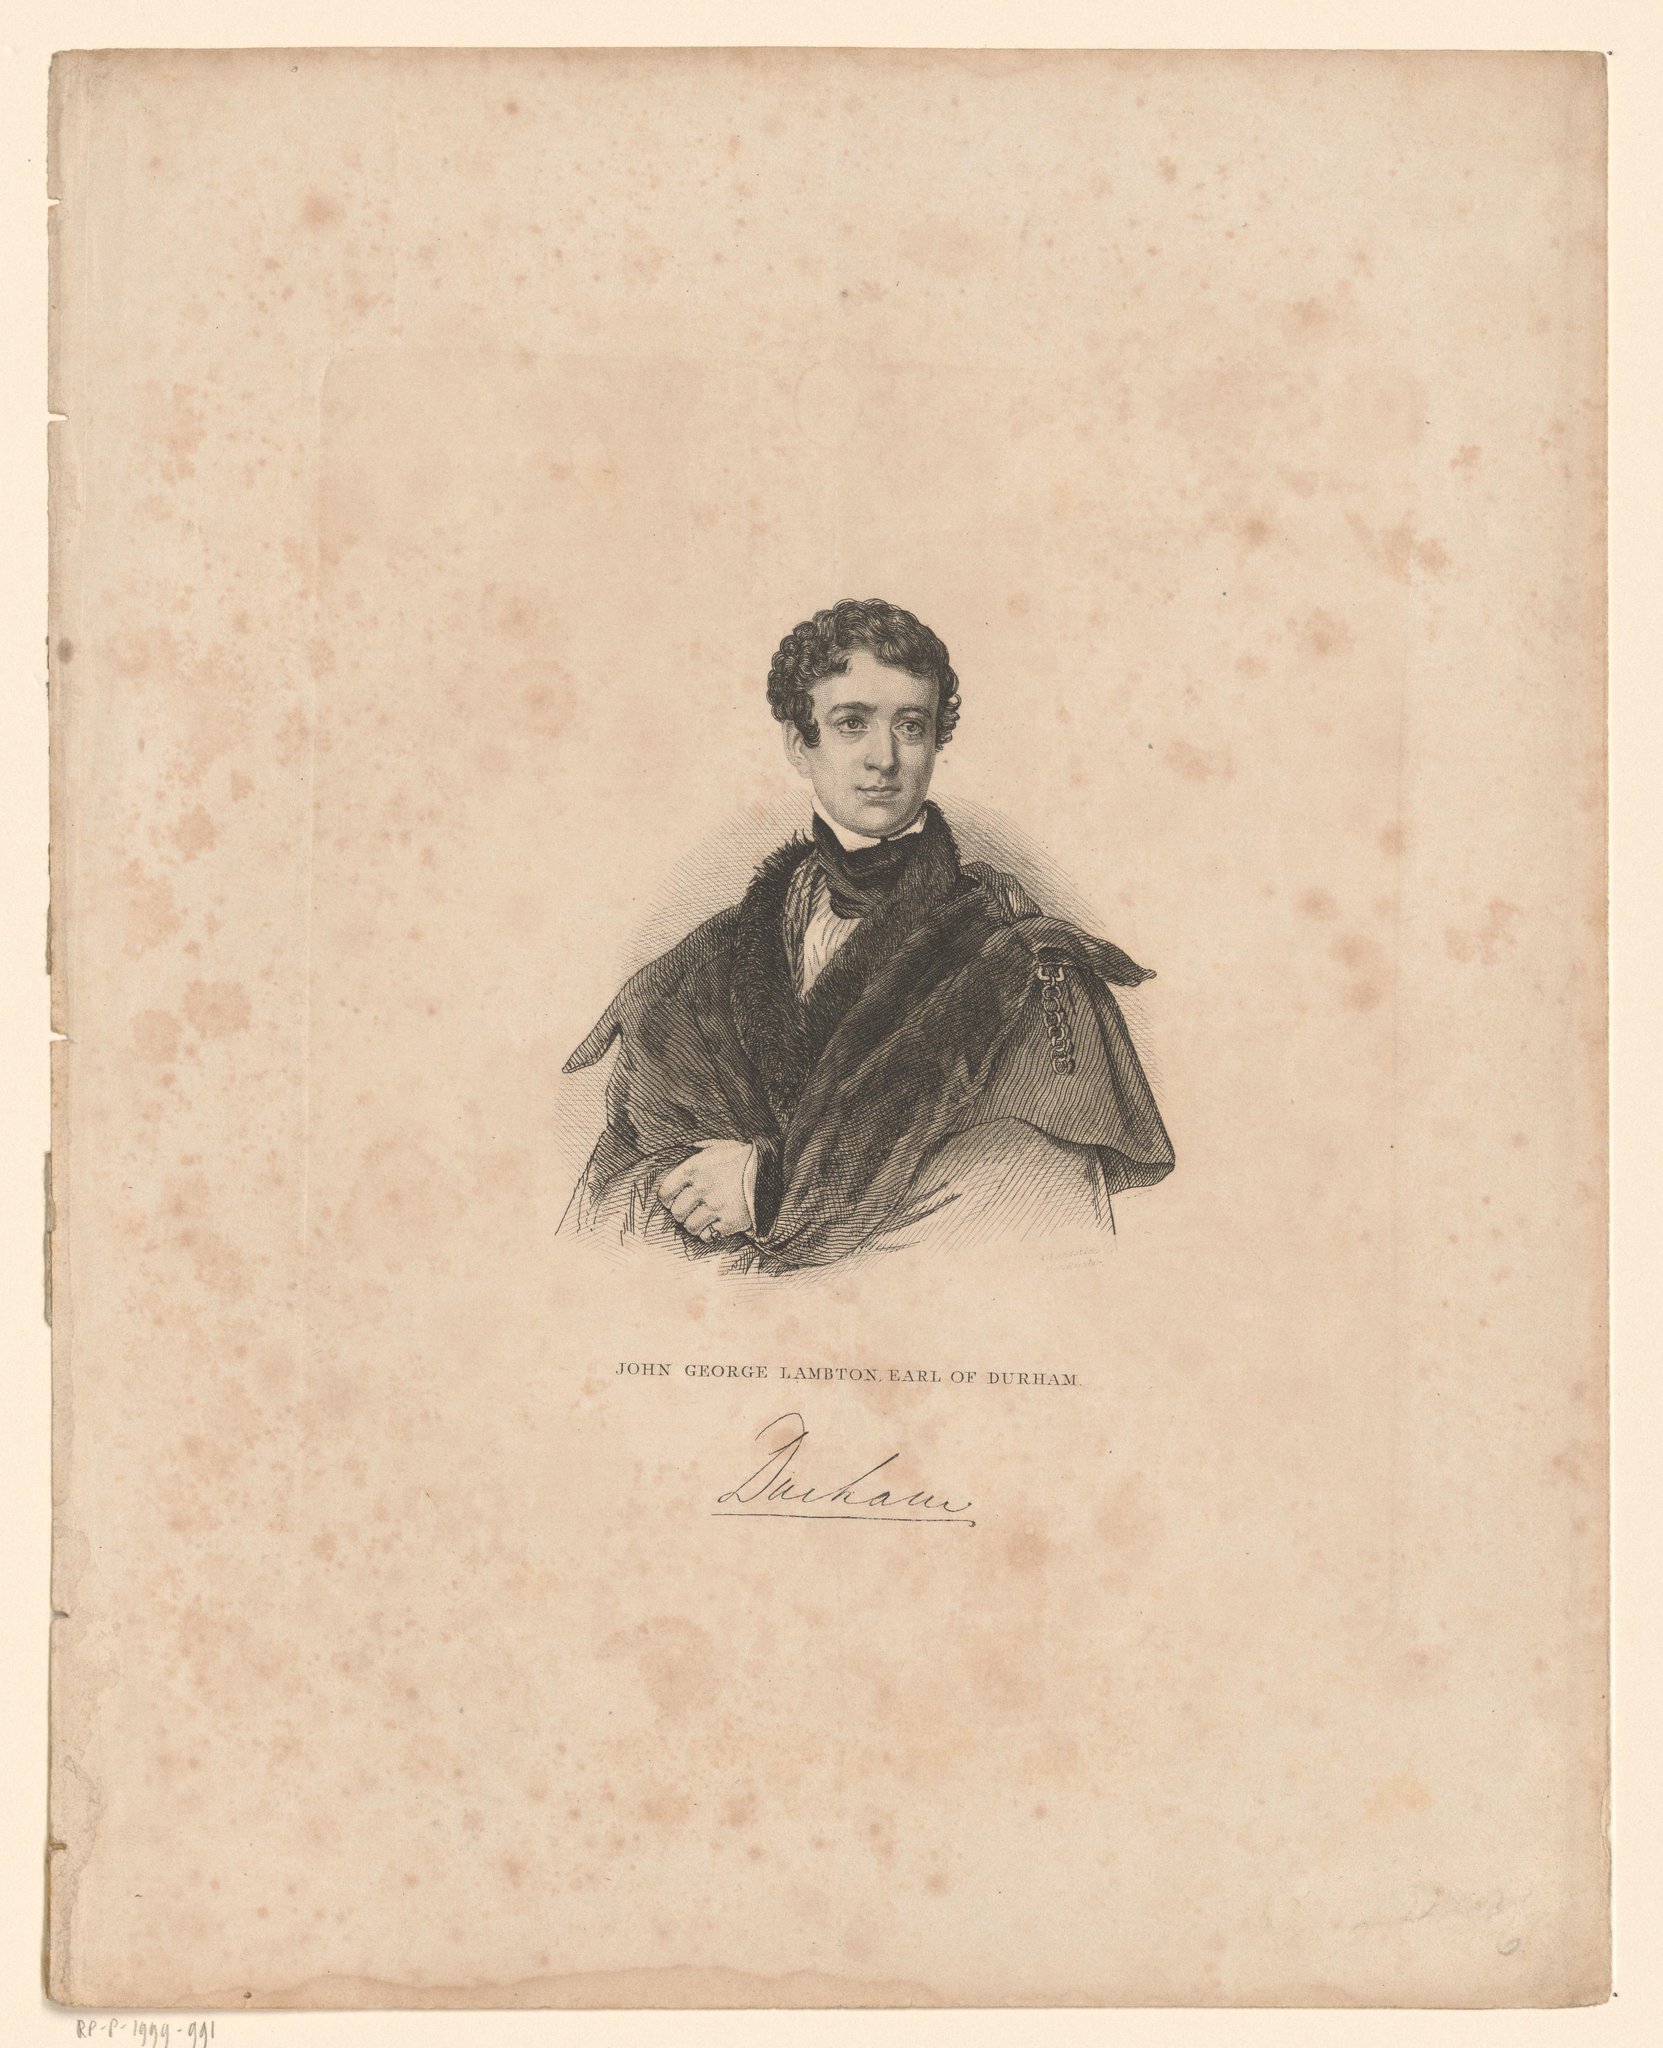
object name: print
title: Portret van John George Lambton, 1e graaf van Durham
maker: richter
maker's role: print maker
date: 1810-1898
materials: paper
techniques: engraving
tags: historical persons, governor, etc. of province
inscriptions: collector's mark: Lugt 2228, collector's mark: Lugt 2760